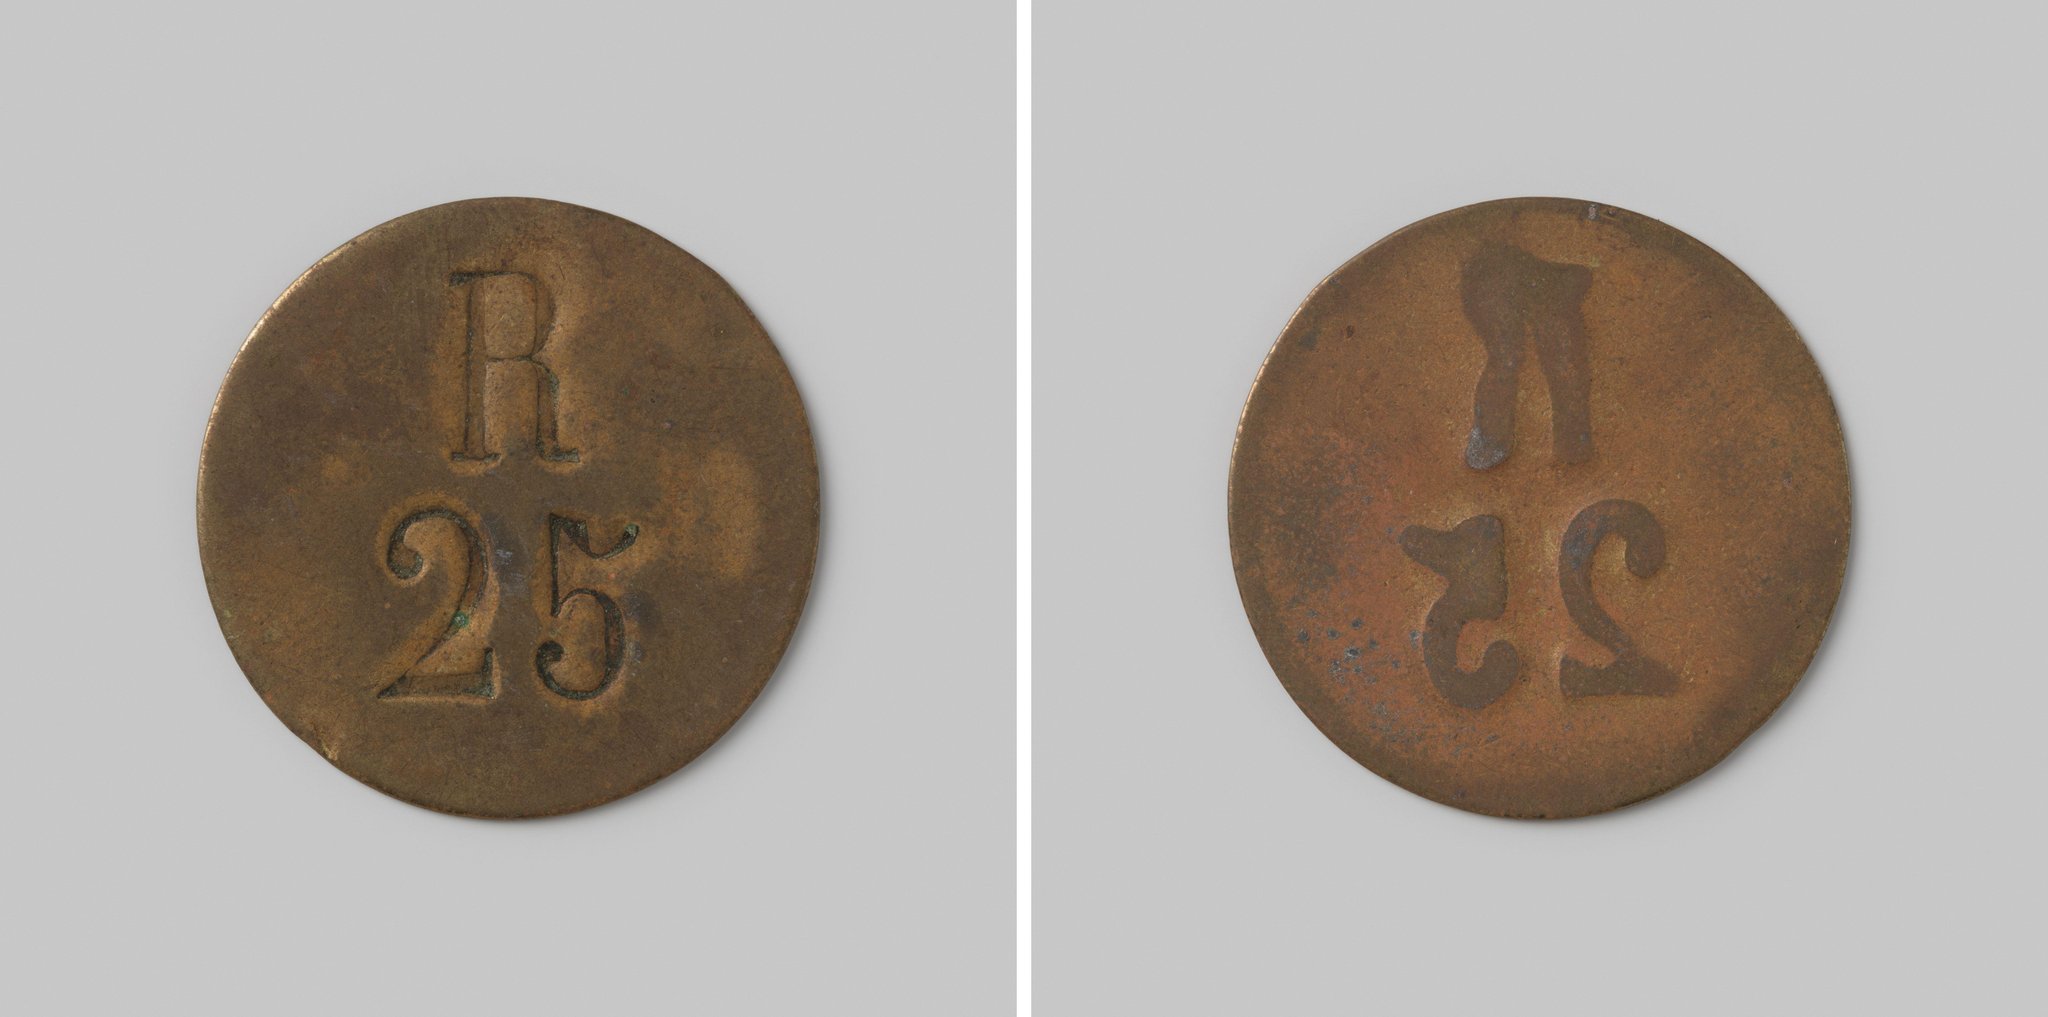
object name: history medal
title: Betaalpenning van 25 cents van Hotel-Cafe Du Commerce te Amsterdam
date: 1875-1900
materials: brass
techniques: printing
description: Messing plaatje met instempelingen R en 25